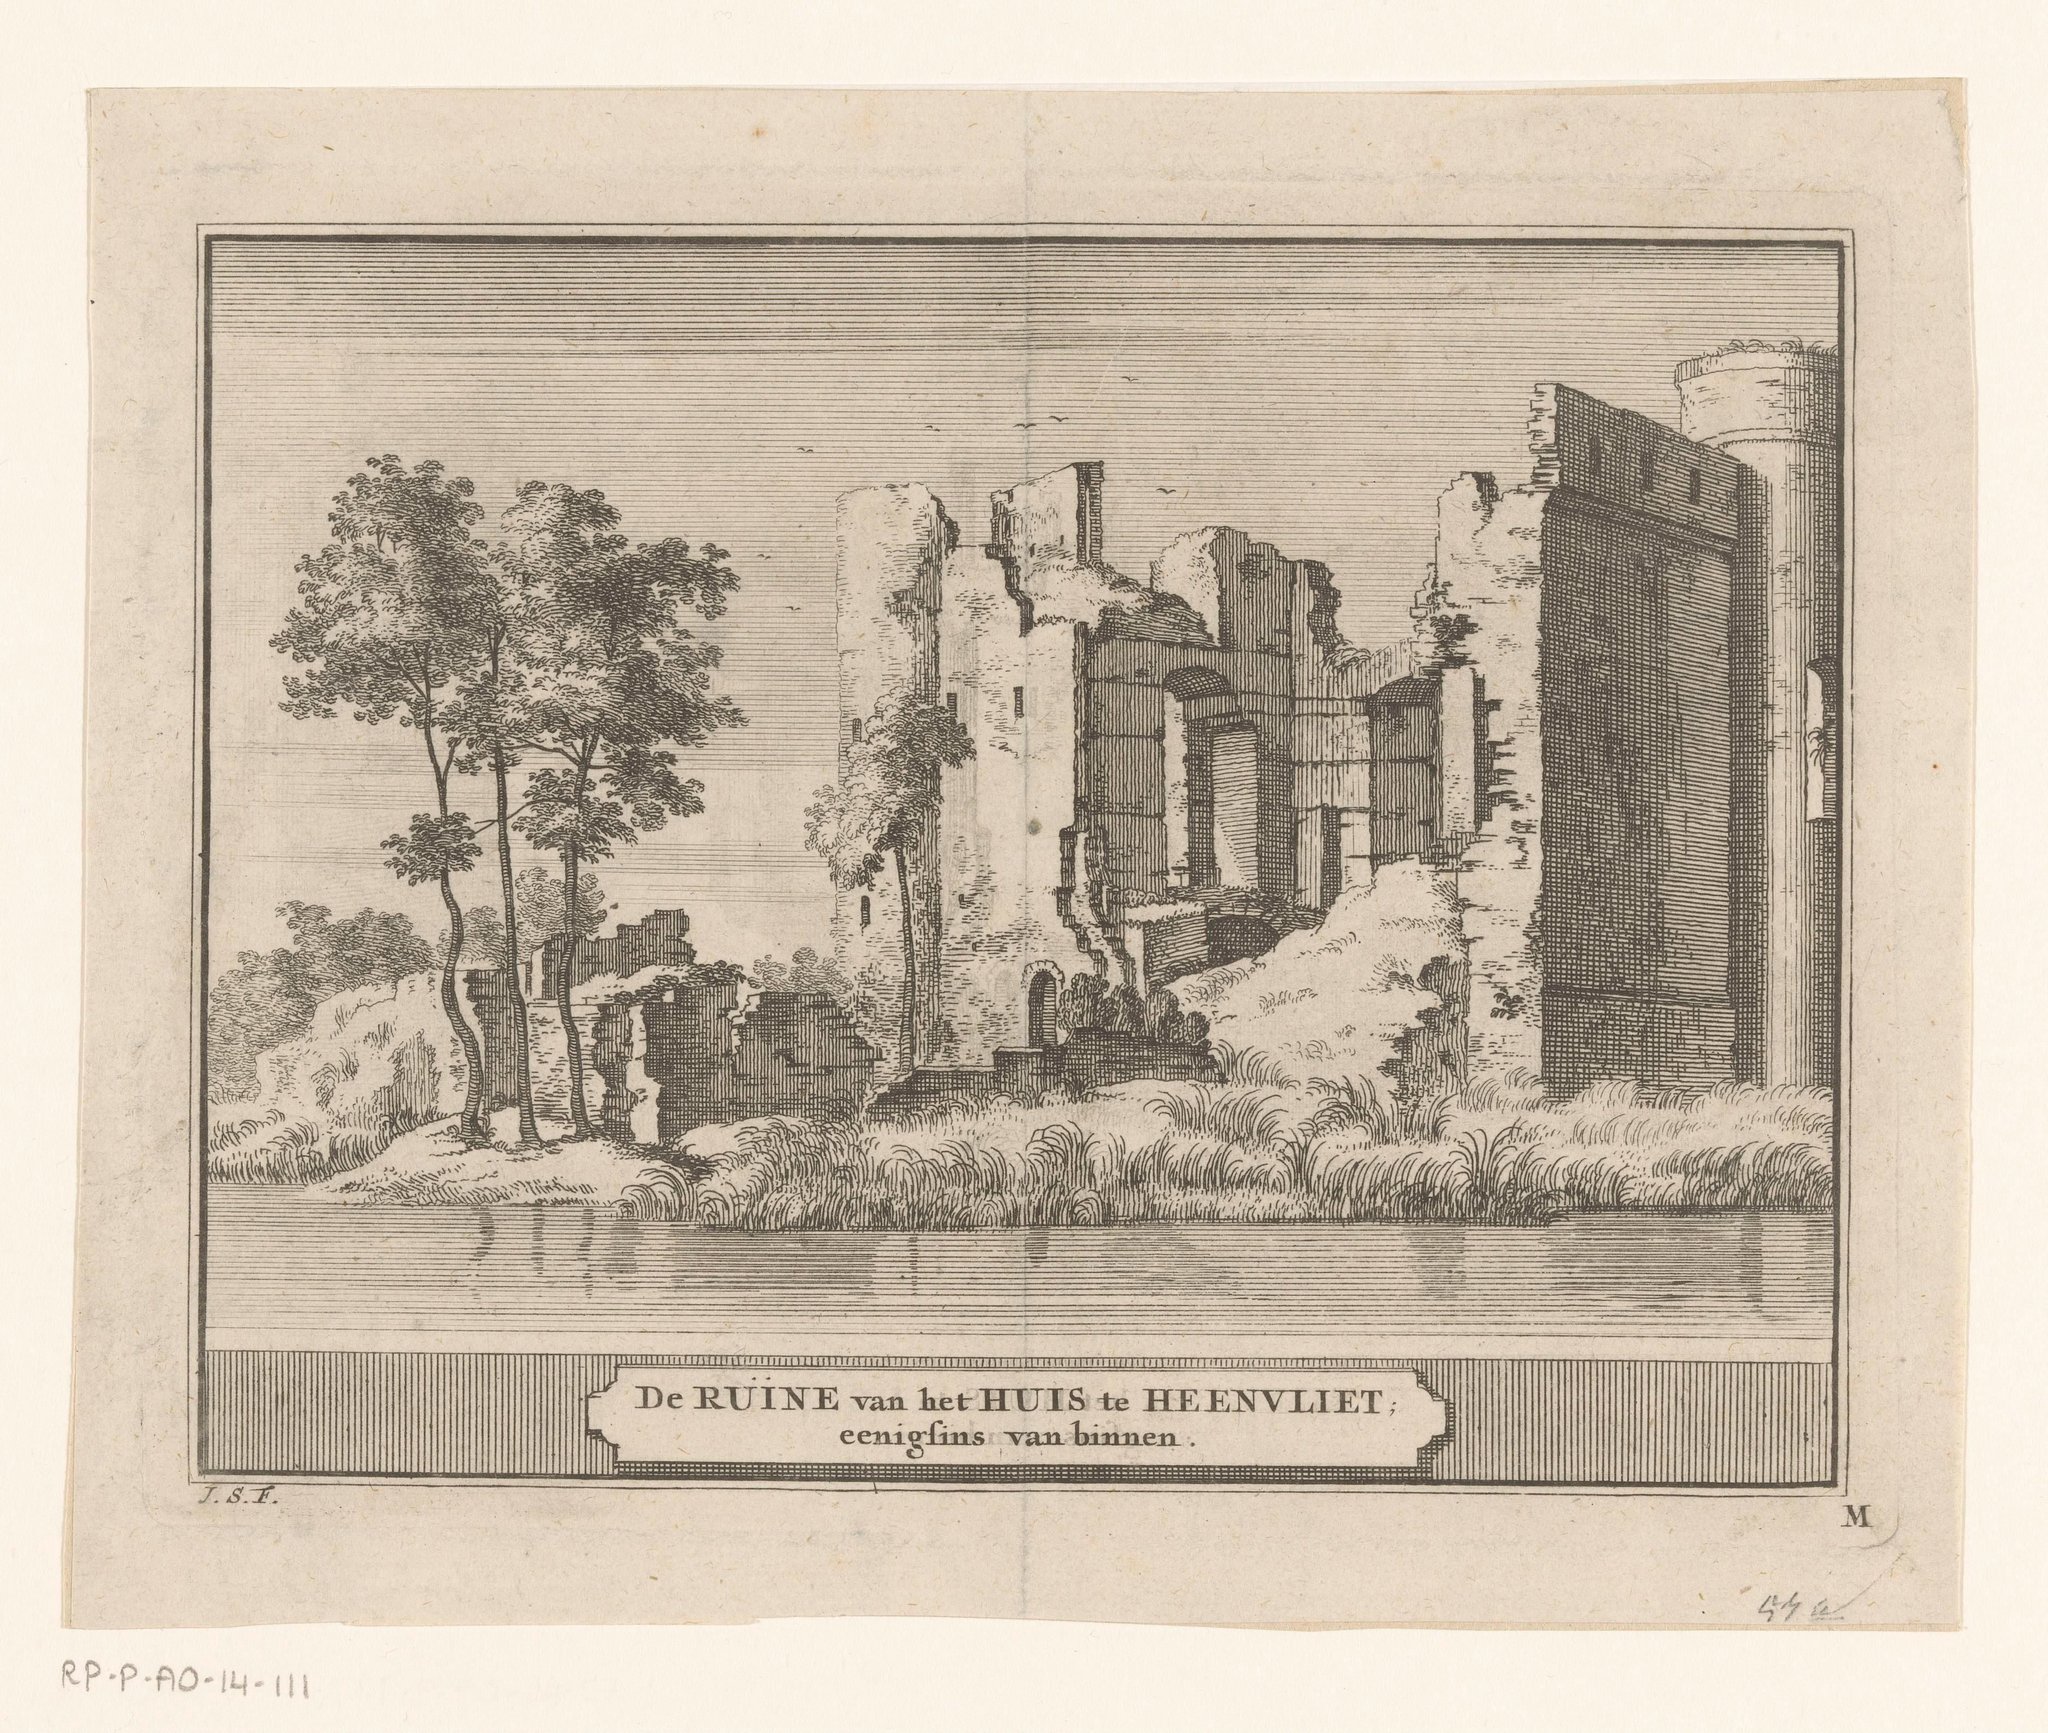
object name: print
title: De ruïne van het huis te Heenvliet; eenigsins van binnen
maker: jacobus schijnvoet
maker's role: draughtsman, print maker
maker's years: 1685-1743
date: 1711-1774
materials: paper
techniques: etching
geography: amsterdam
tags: ruin of a dwelling, house, castle, etc.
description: Prent ook gebruikt in: Smids, Ludolf. Schatkamer der Nederlandsse oudheden; of woordenboek, behelsende Nederlands steden en dorpen, kasteelen, sloten en heeren huysen (…). Amsterdam: Pieter de Coup, 1711, tussen p. 132 en 133. Het is ook mogelijk dat deze prent uit de tweede (1737) of derde (1774) druk komt, of uit een uitgave met alleen de prenten: Nederlandsche oudheden, bestaande in zestig verbeeldingen (...) gelegen in Holland, 't Sticht van Utrecht en Gelderland enz. Amsterdam: Hendrik Bosch, 1721. Zie RP-T-1900-A-4336 voor de tekening waar deze prent op is gebaseerd.